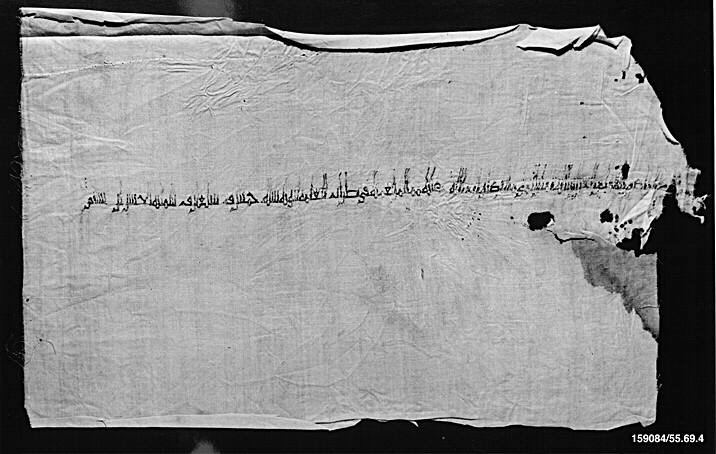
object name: textile fragment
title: Tiraz Fragment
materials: linen, silk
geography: egypt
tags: arabic